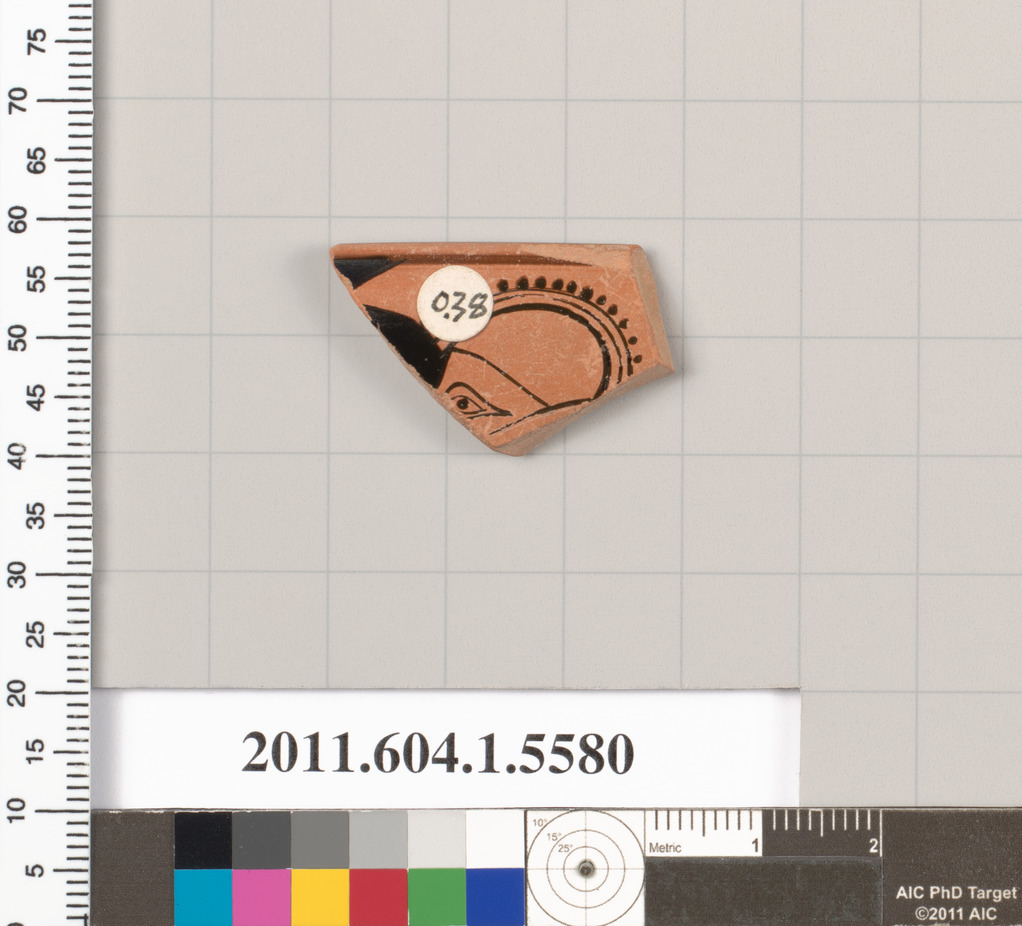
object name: kylix fragment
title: Terracotta rim fragment of a kylix (drinking cup)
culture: greek, attic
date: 520-500 BCE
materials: terracotta